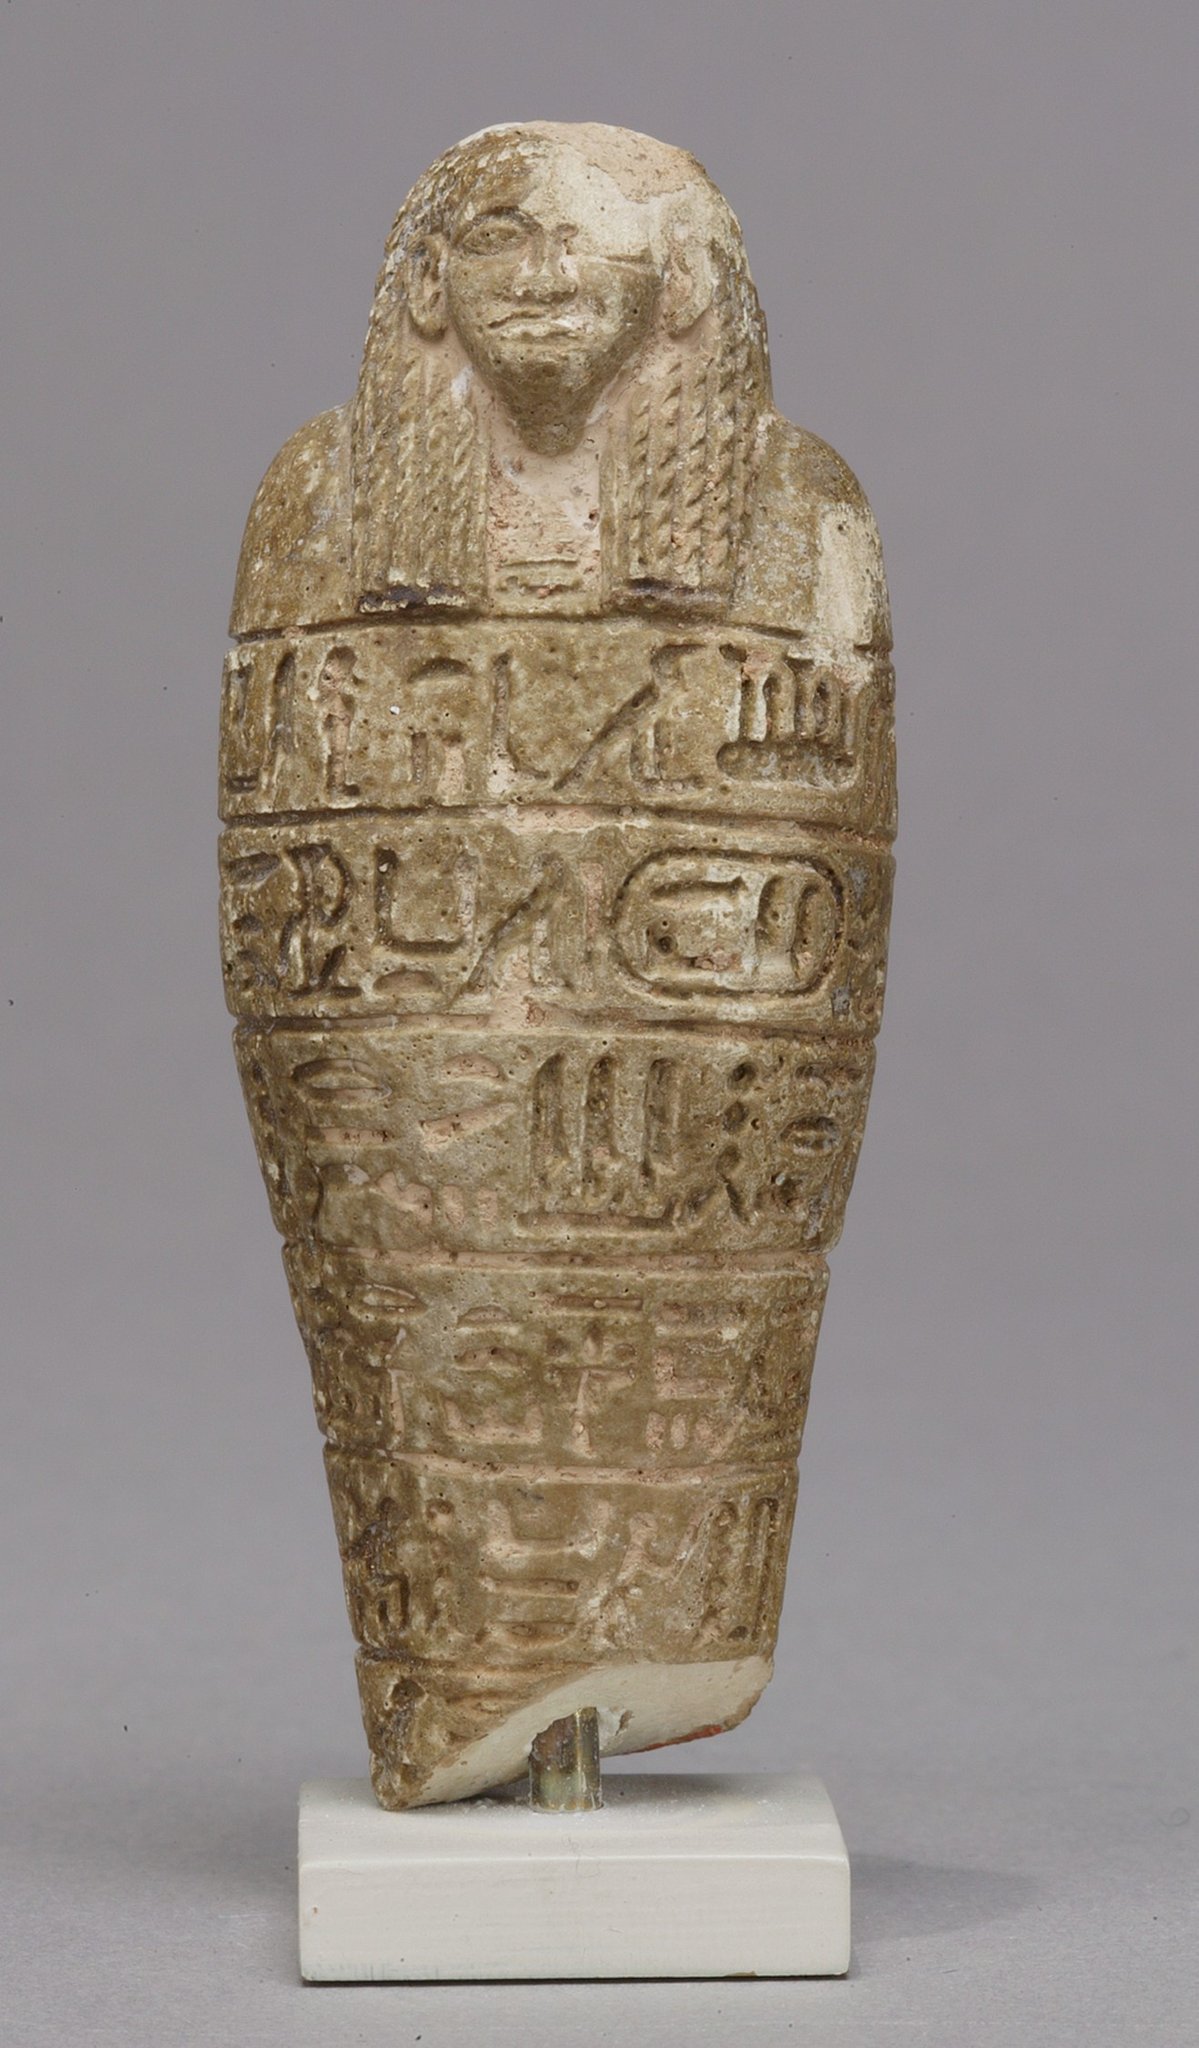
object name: shabti of queen tia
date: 1295-1186 BCE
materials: faience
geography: egypt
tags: hieroglyphs